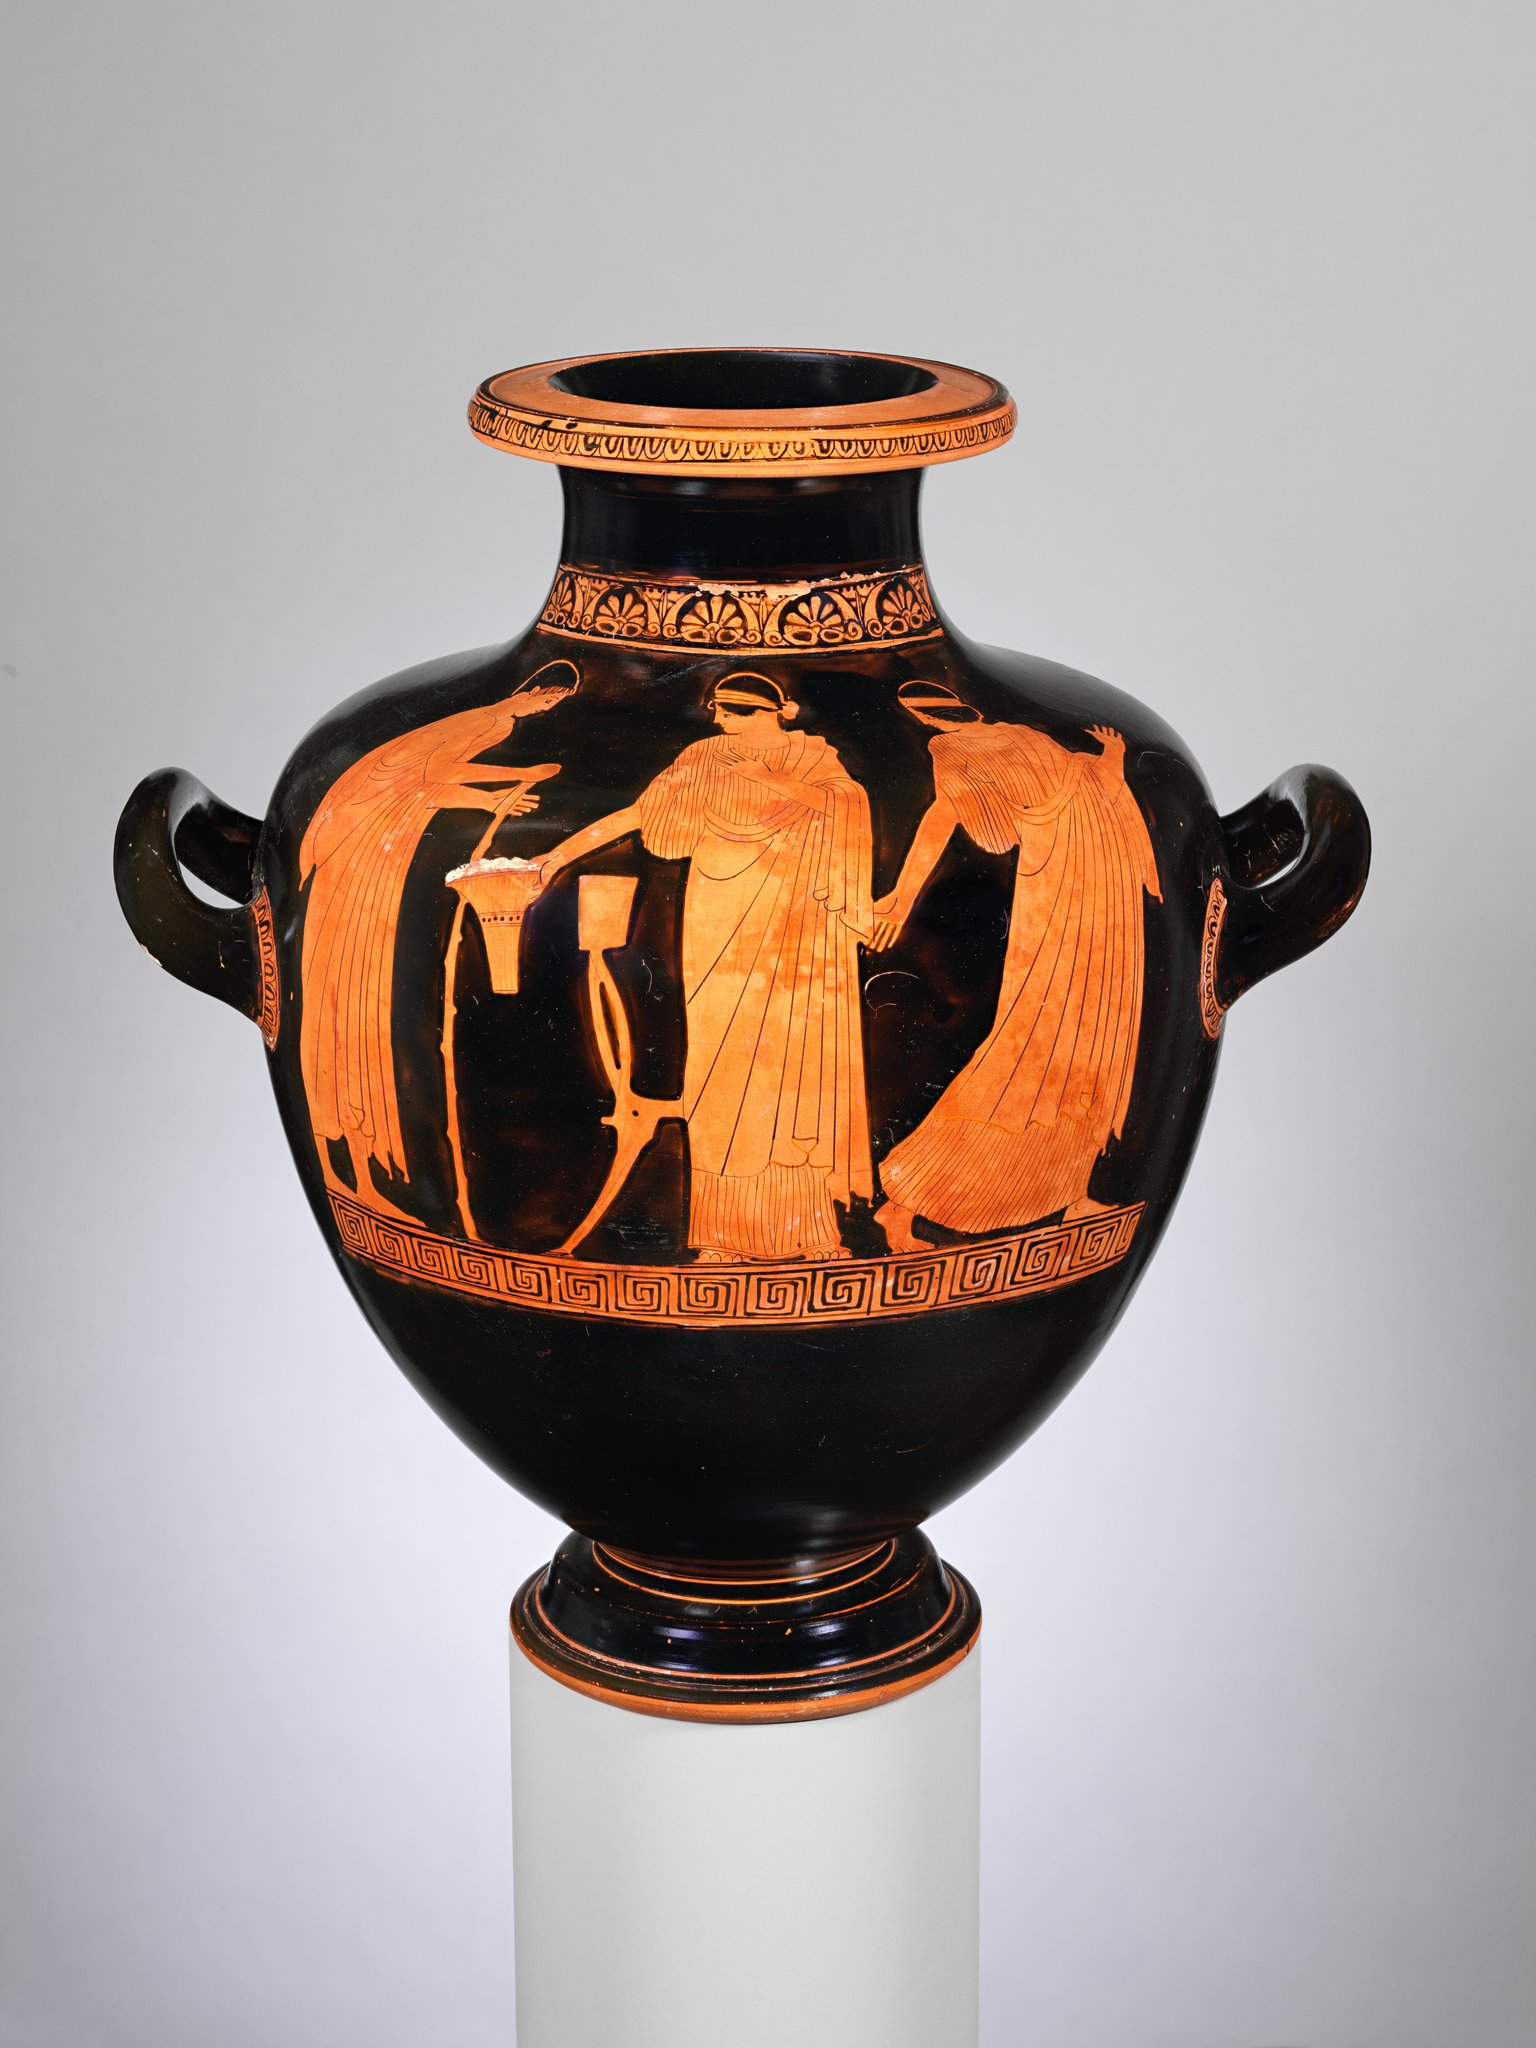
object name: hydria, kalpis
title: Terracotta hydria: kalpis (water jar)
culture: greek, attic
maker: villa giulia painter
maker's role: artist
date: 460-450 BCE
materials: terracotta